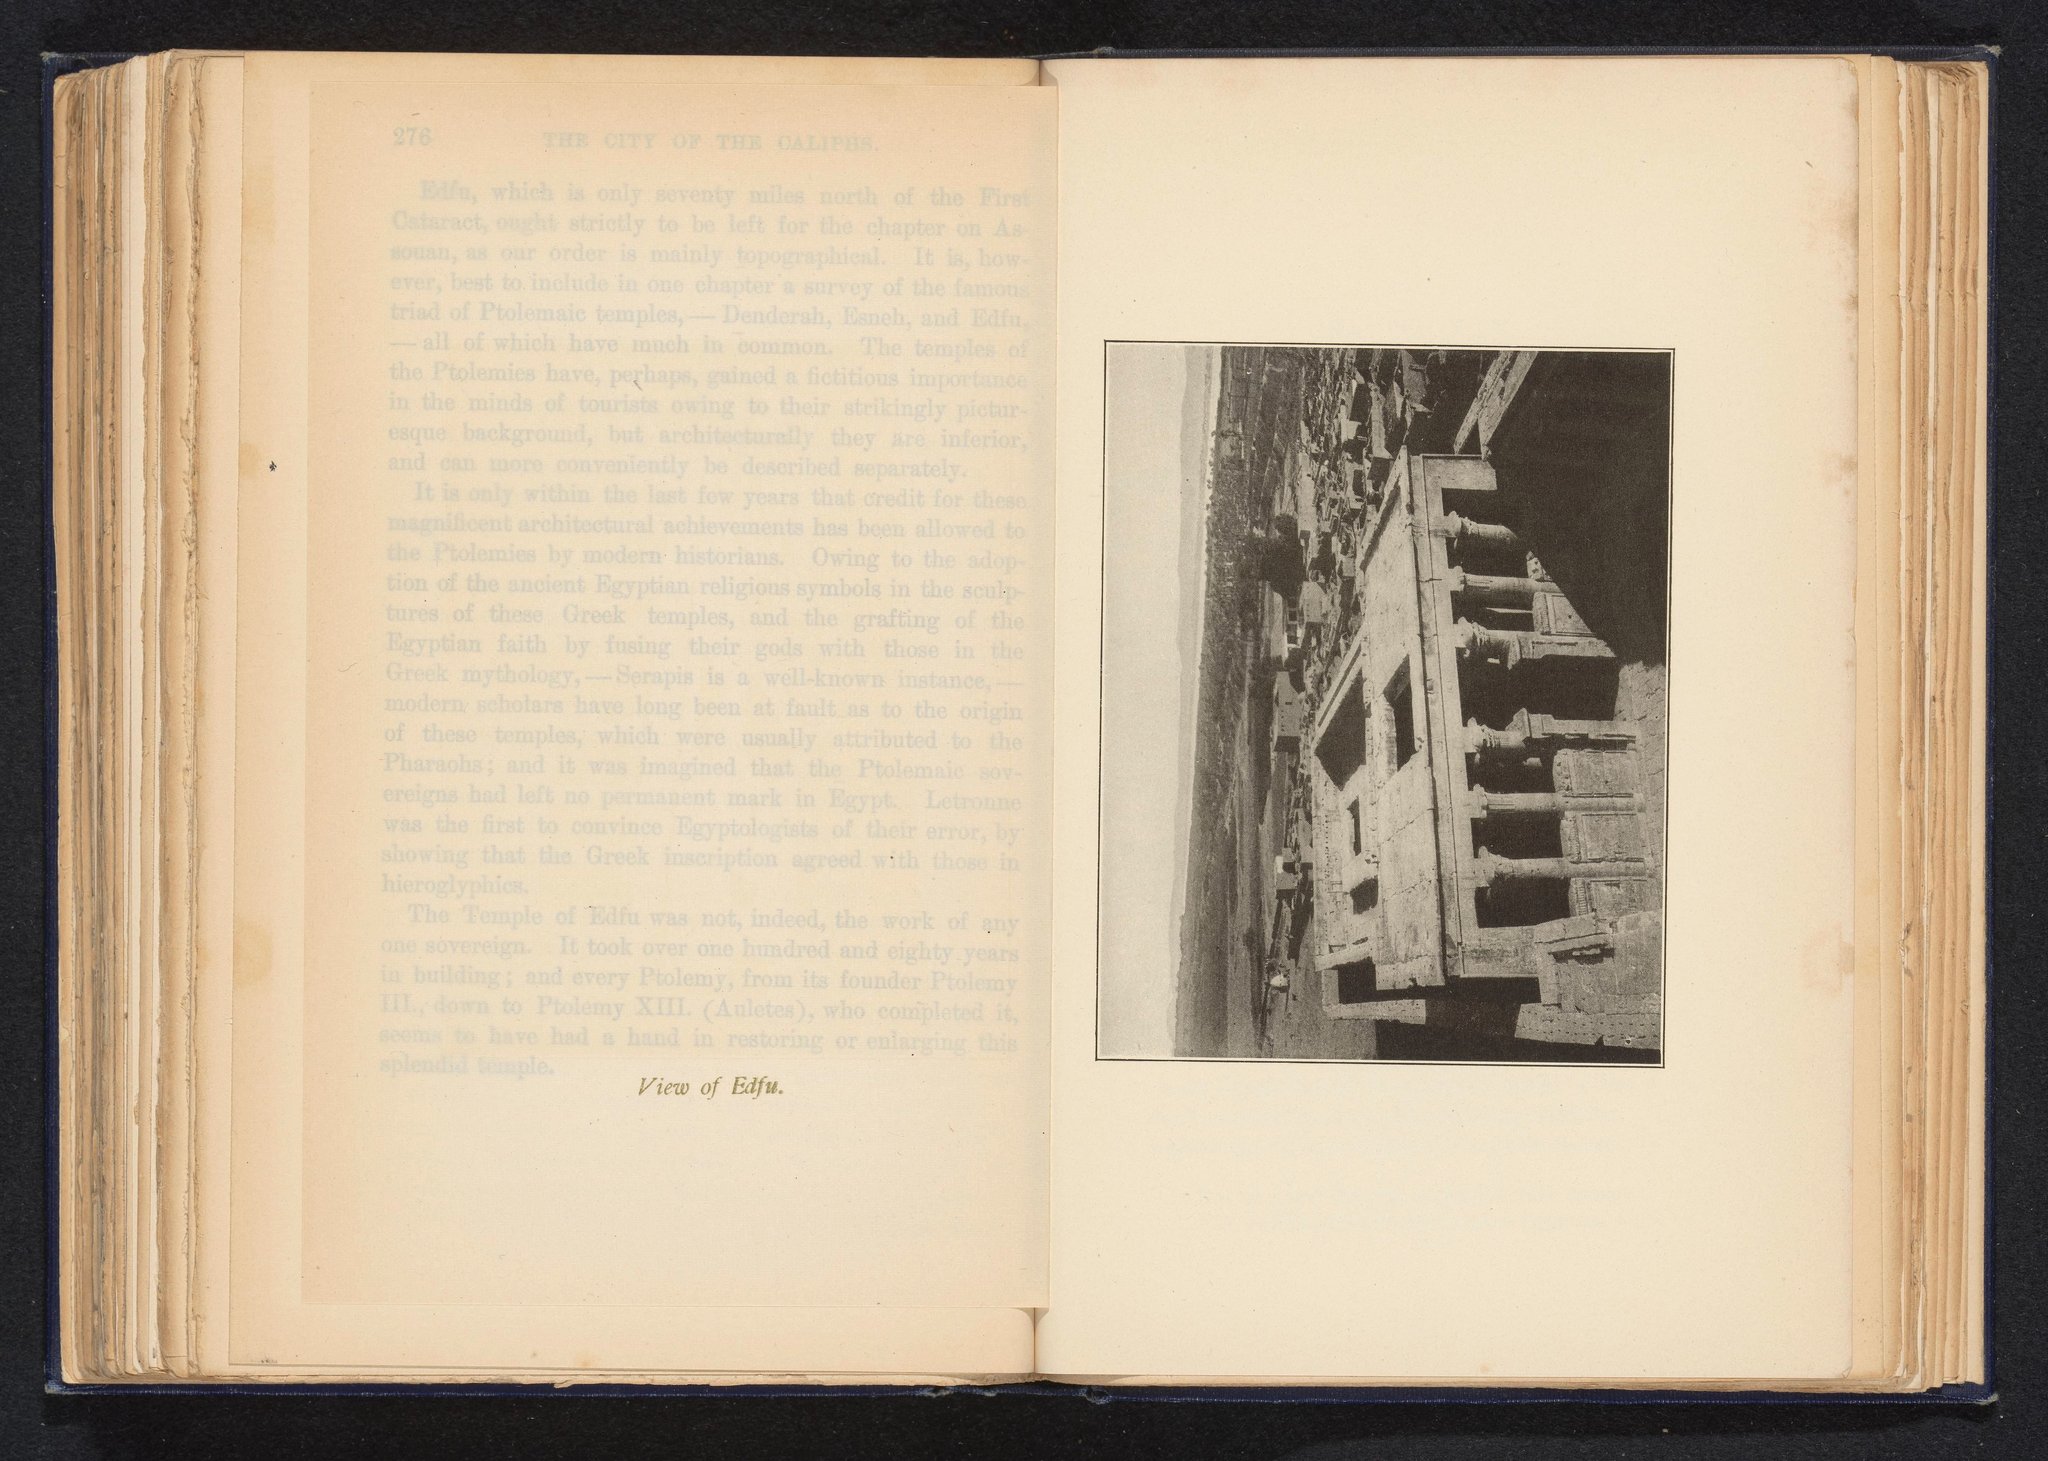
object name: photomechanical print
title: Gezicht op de Tempel van Horus in Edfu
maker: Anonymous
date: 1891-1901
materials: paper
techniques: autotype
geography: edfu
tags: temple, shrine ~ non-christian religions